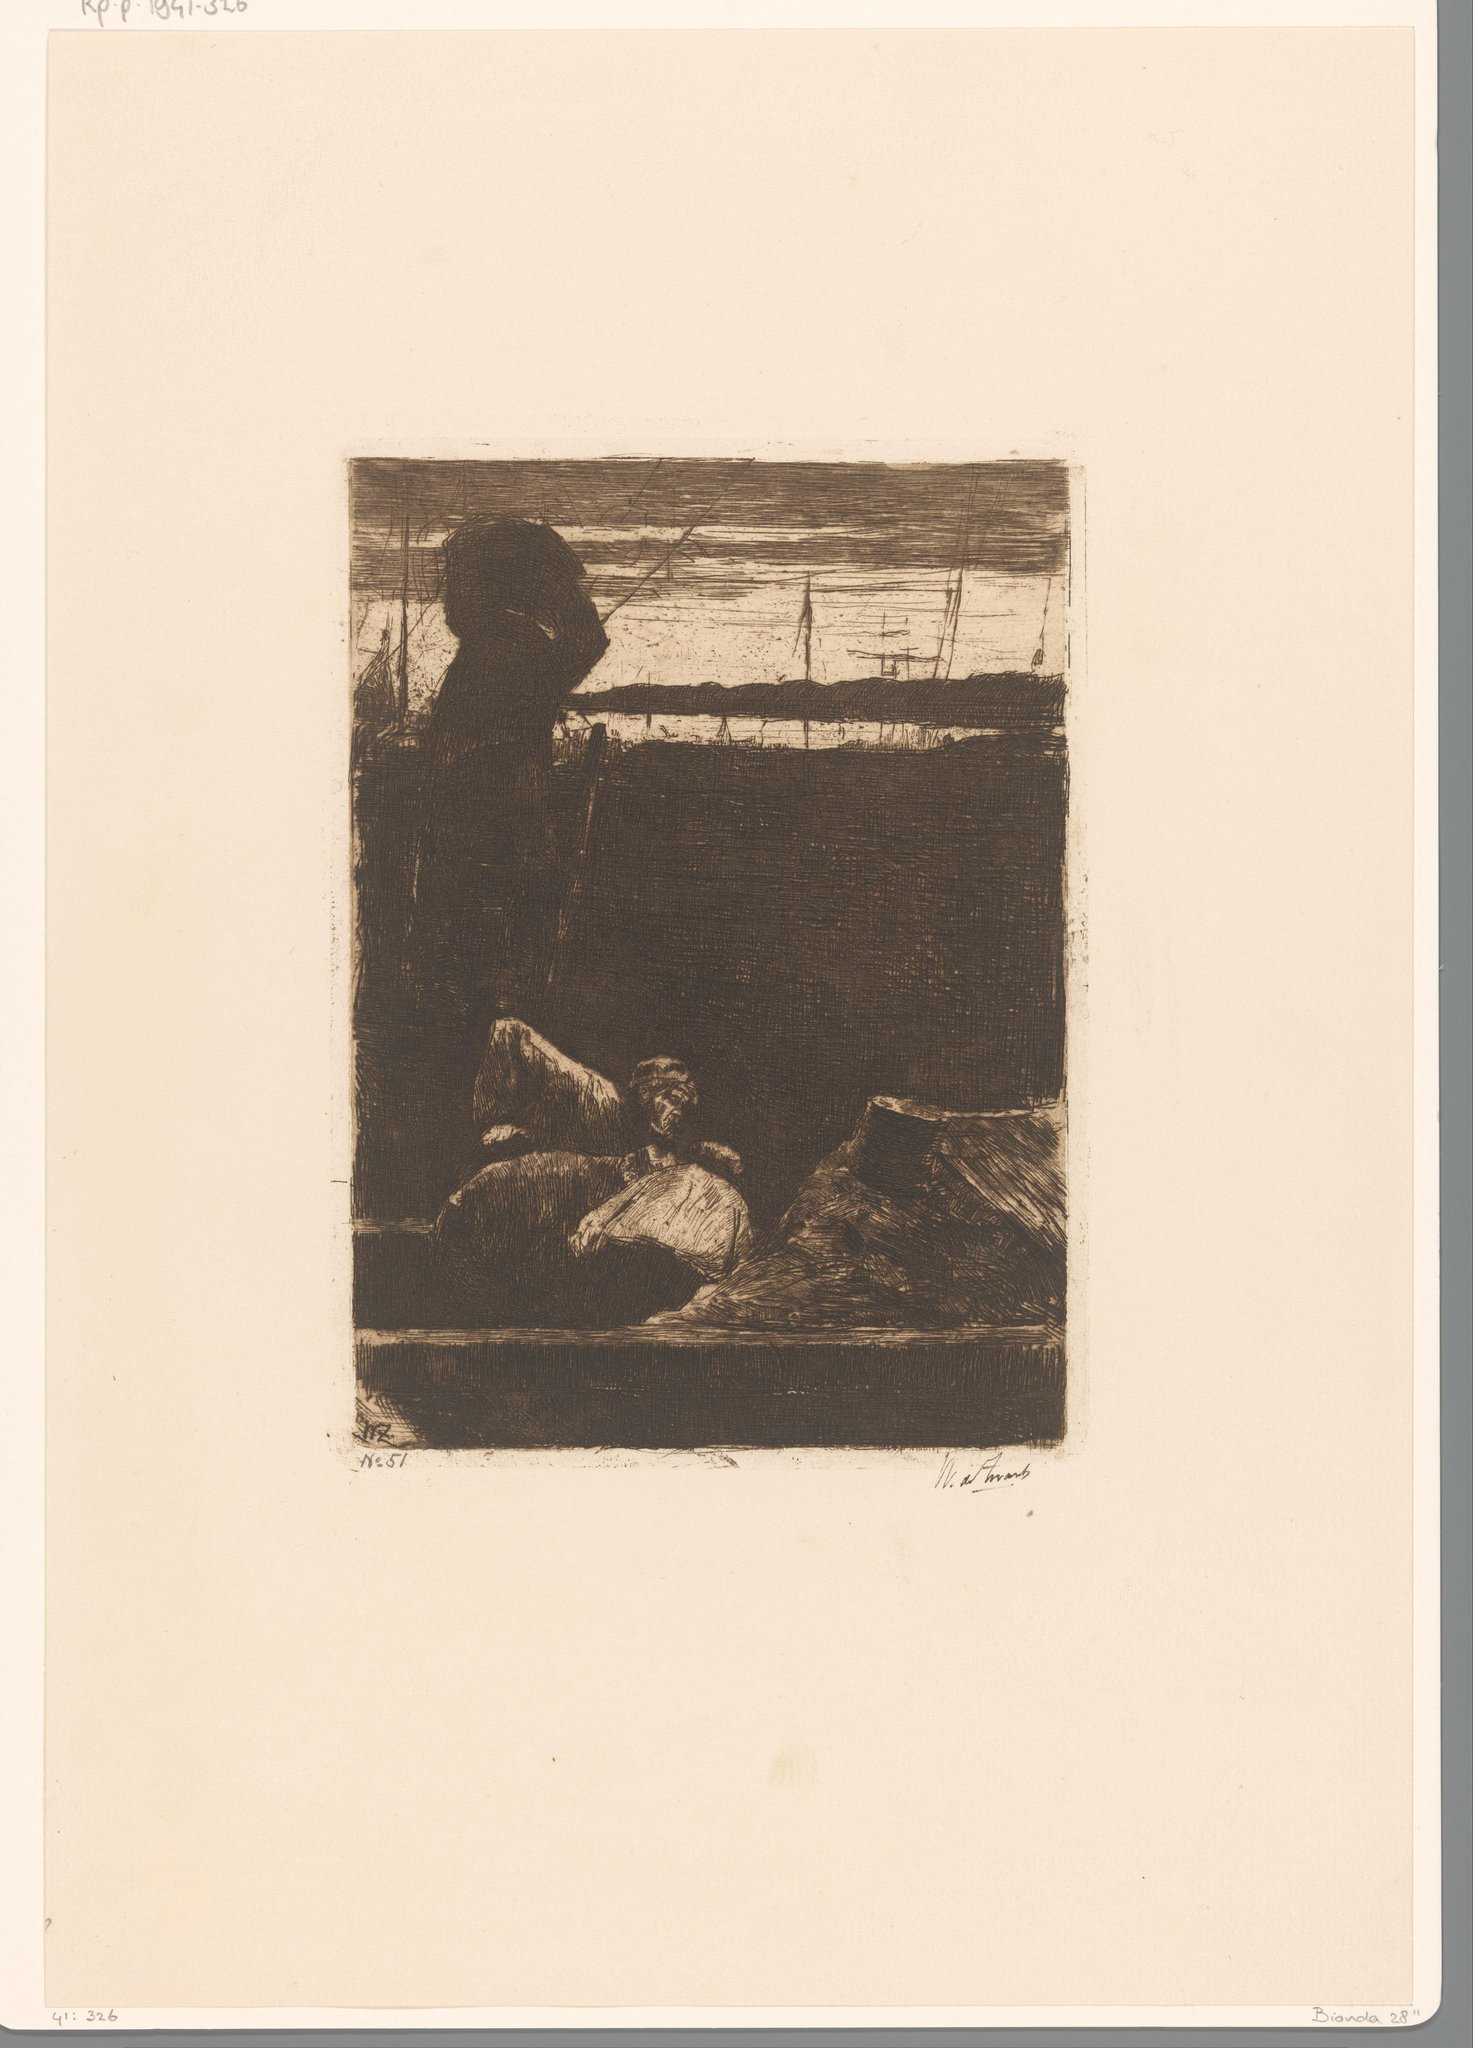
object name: print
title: Kolendragers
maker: willem de zwart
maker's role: draughtsman, painter, print maker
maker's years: 1862-1931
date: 1886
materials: paper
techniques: drypoint, etching, intaglio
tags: harbour, coal-shovel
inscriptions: collector's mark: Lugt 2760, collector's mark: Lugt 2228